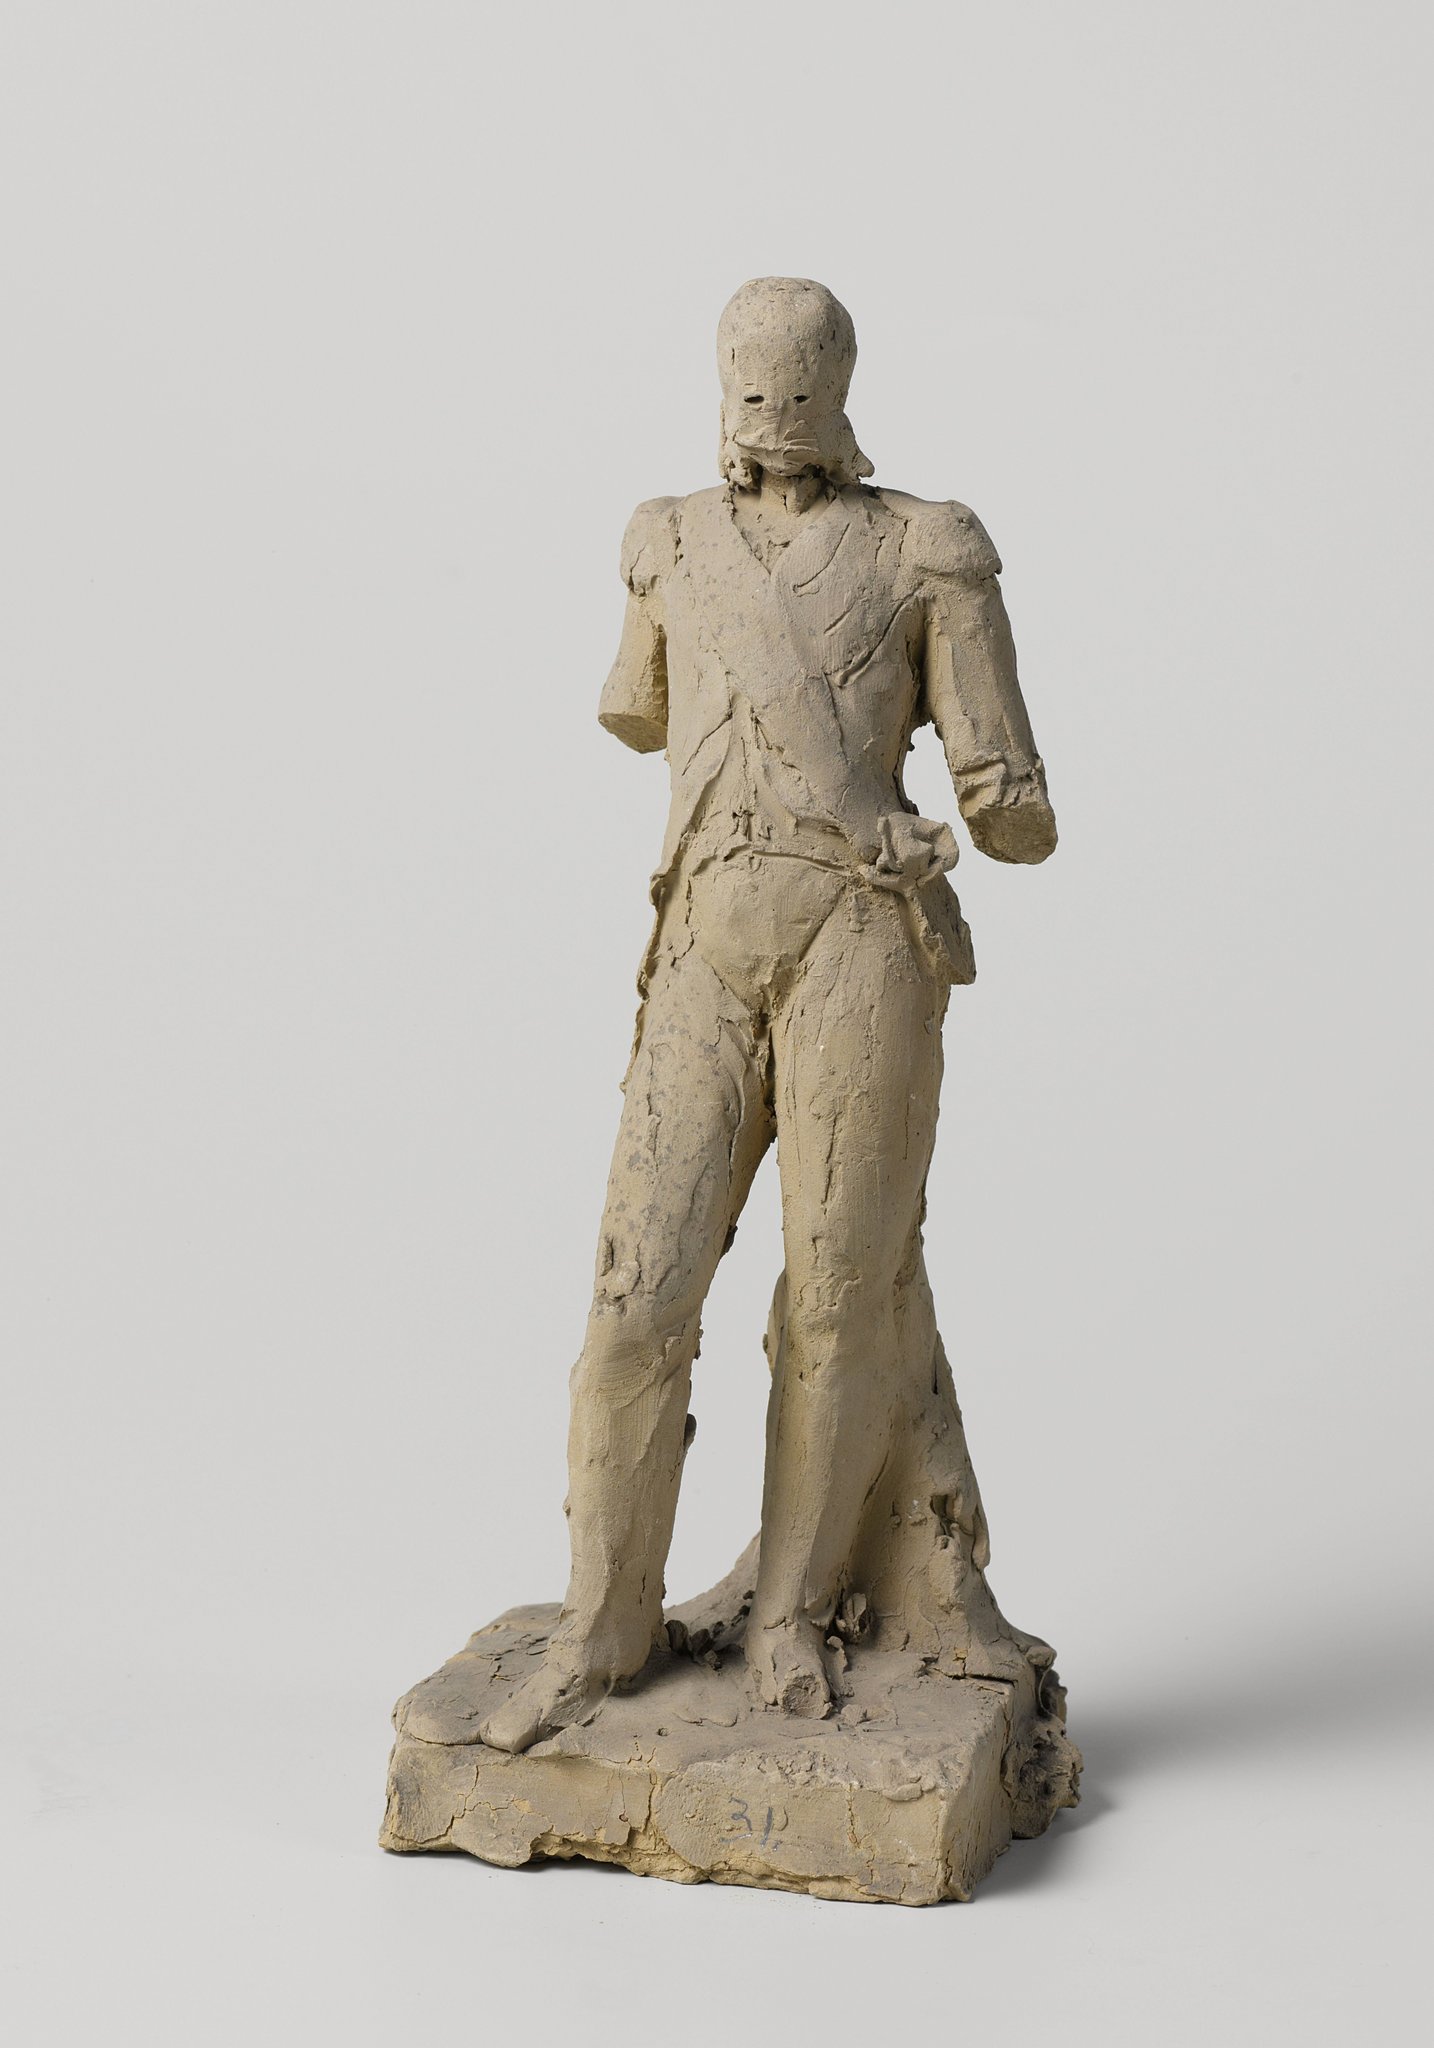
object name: sculpture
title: Schets voor een monument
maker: eugène lacomblé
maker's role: draughtsman, painter, sculptor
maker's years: 1828-1905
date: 1800-1900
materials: clay